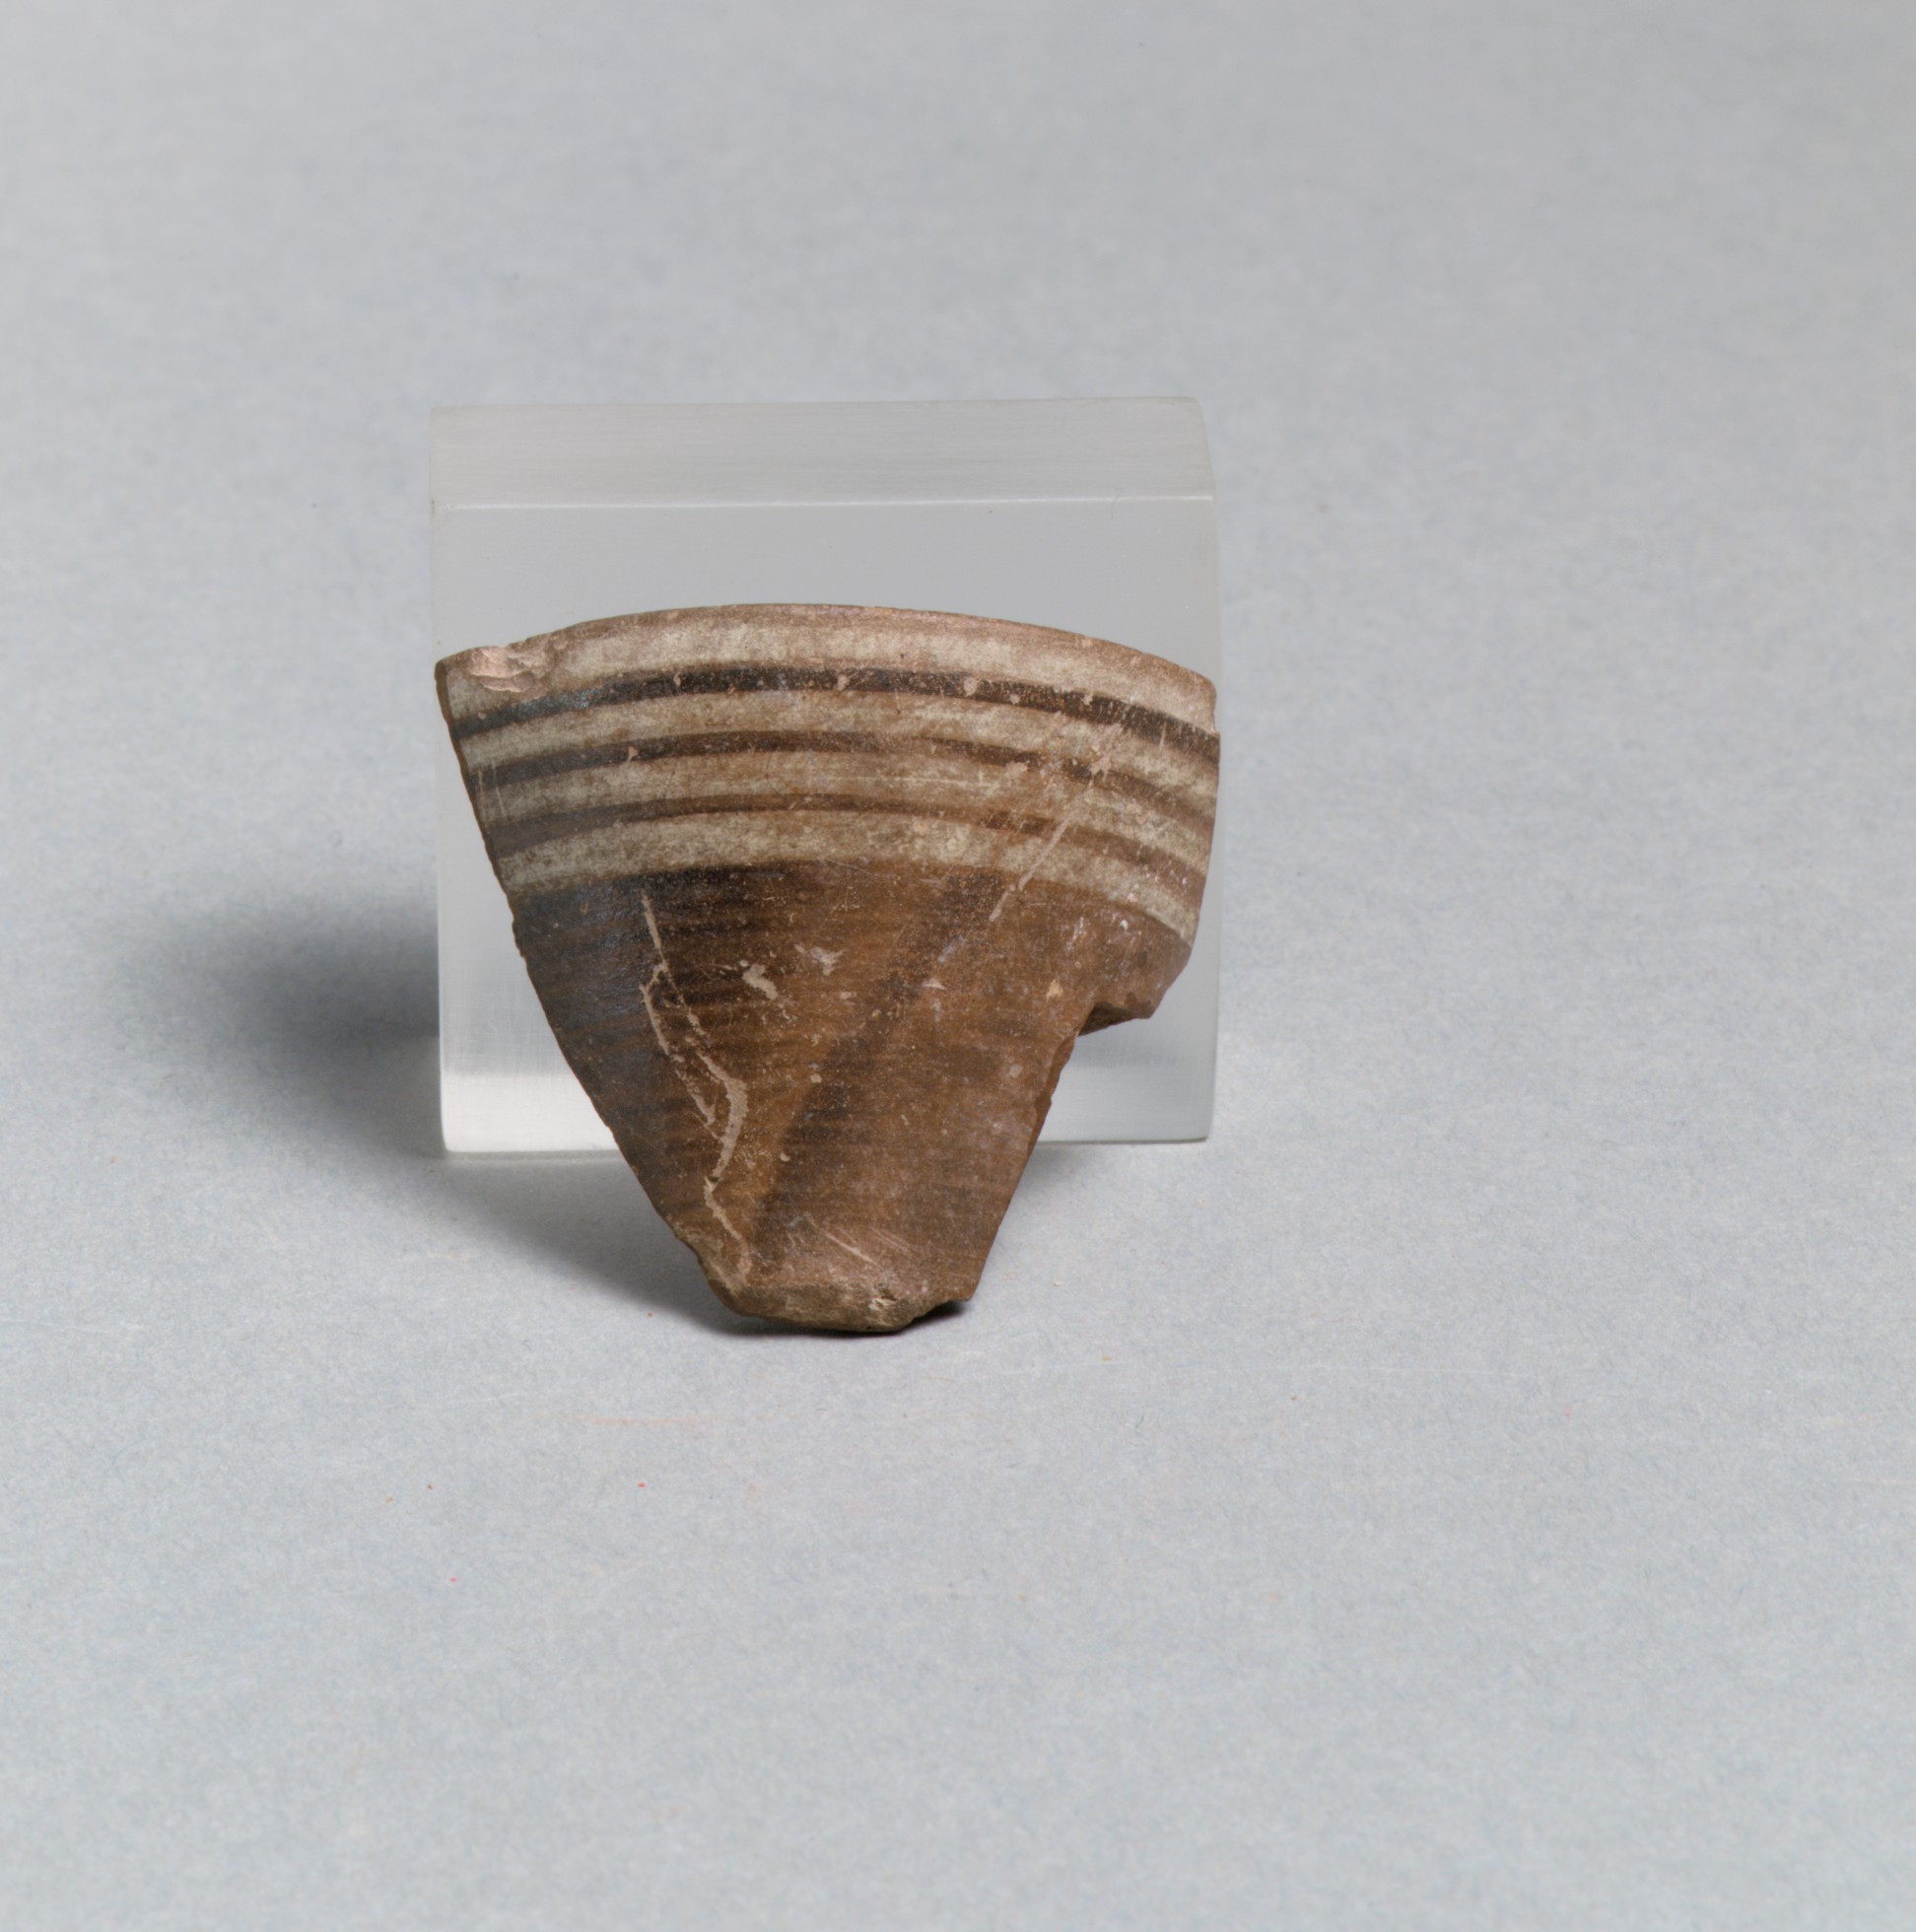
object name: vase fragment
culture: greek or lydian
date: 900-30 BCE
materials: terracotta